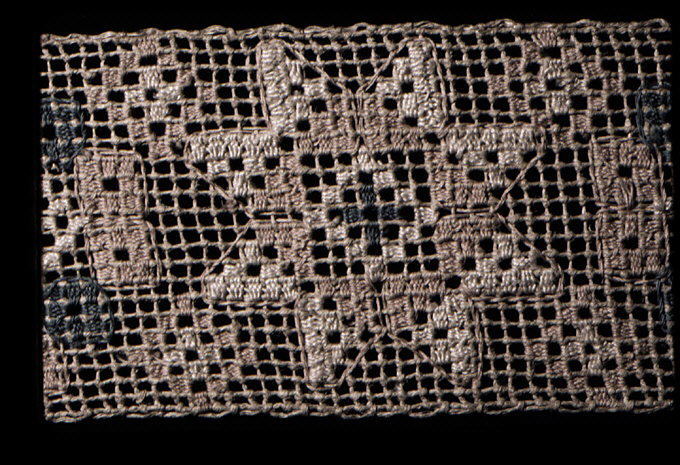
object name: insertion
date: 1801-1900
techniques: embroidery